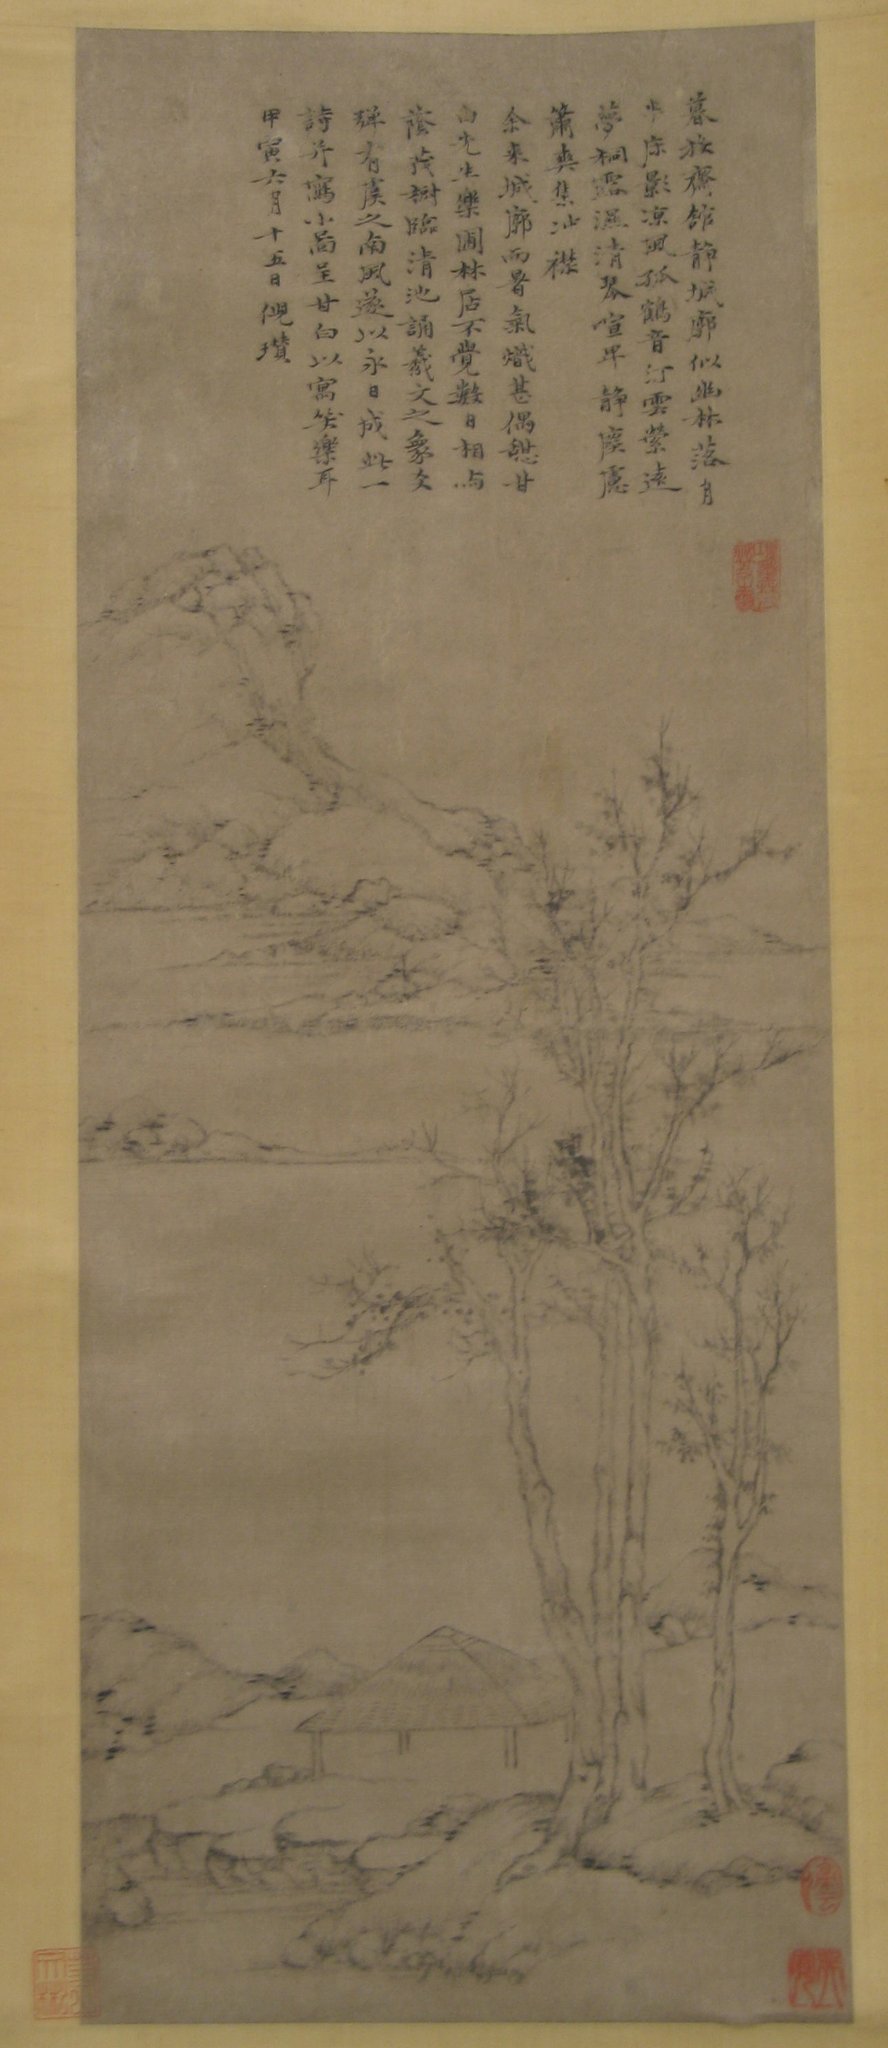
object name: hanging scroll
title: Landscape after Ni Zan (1306–1374)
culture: chinese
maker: unidentified artist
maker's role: artist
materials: ink, paper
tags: mountains,landscapes